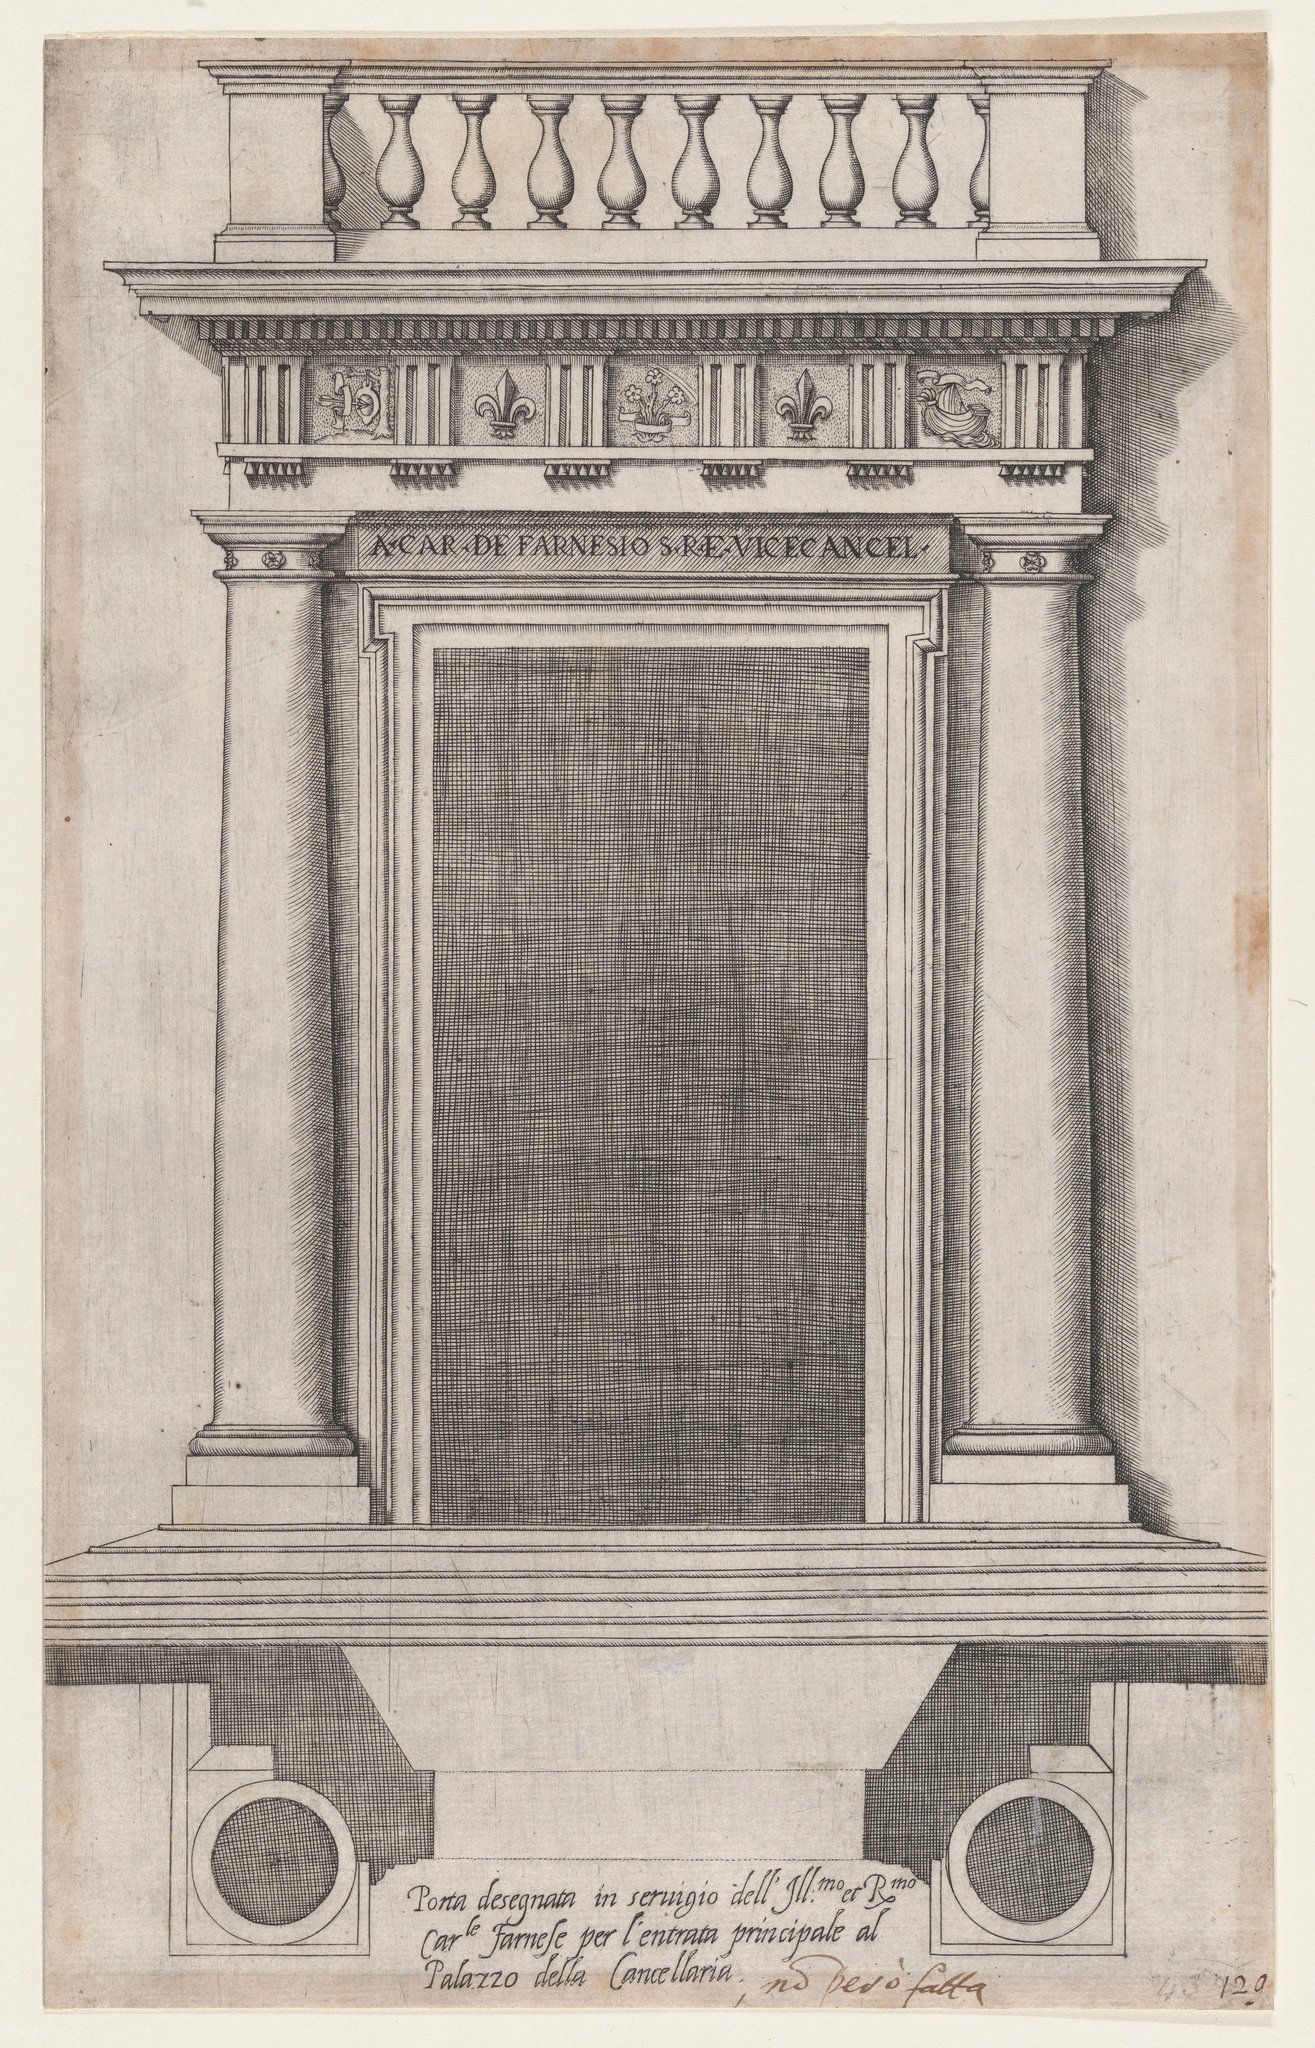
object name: print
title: The Main Doorway of the Palazzo della Cancellaria, from "Speculum Romanae Magnificentiae"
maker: Anonymous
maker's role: artist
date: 1501-1600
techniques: engraving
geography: rome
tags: architecture,doorways,rome